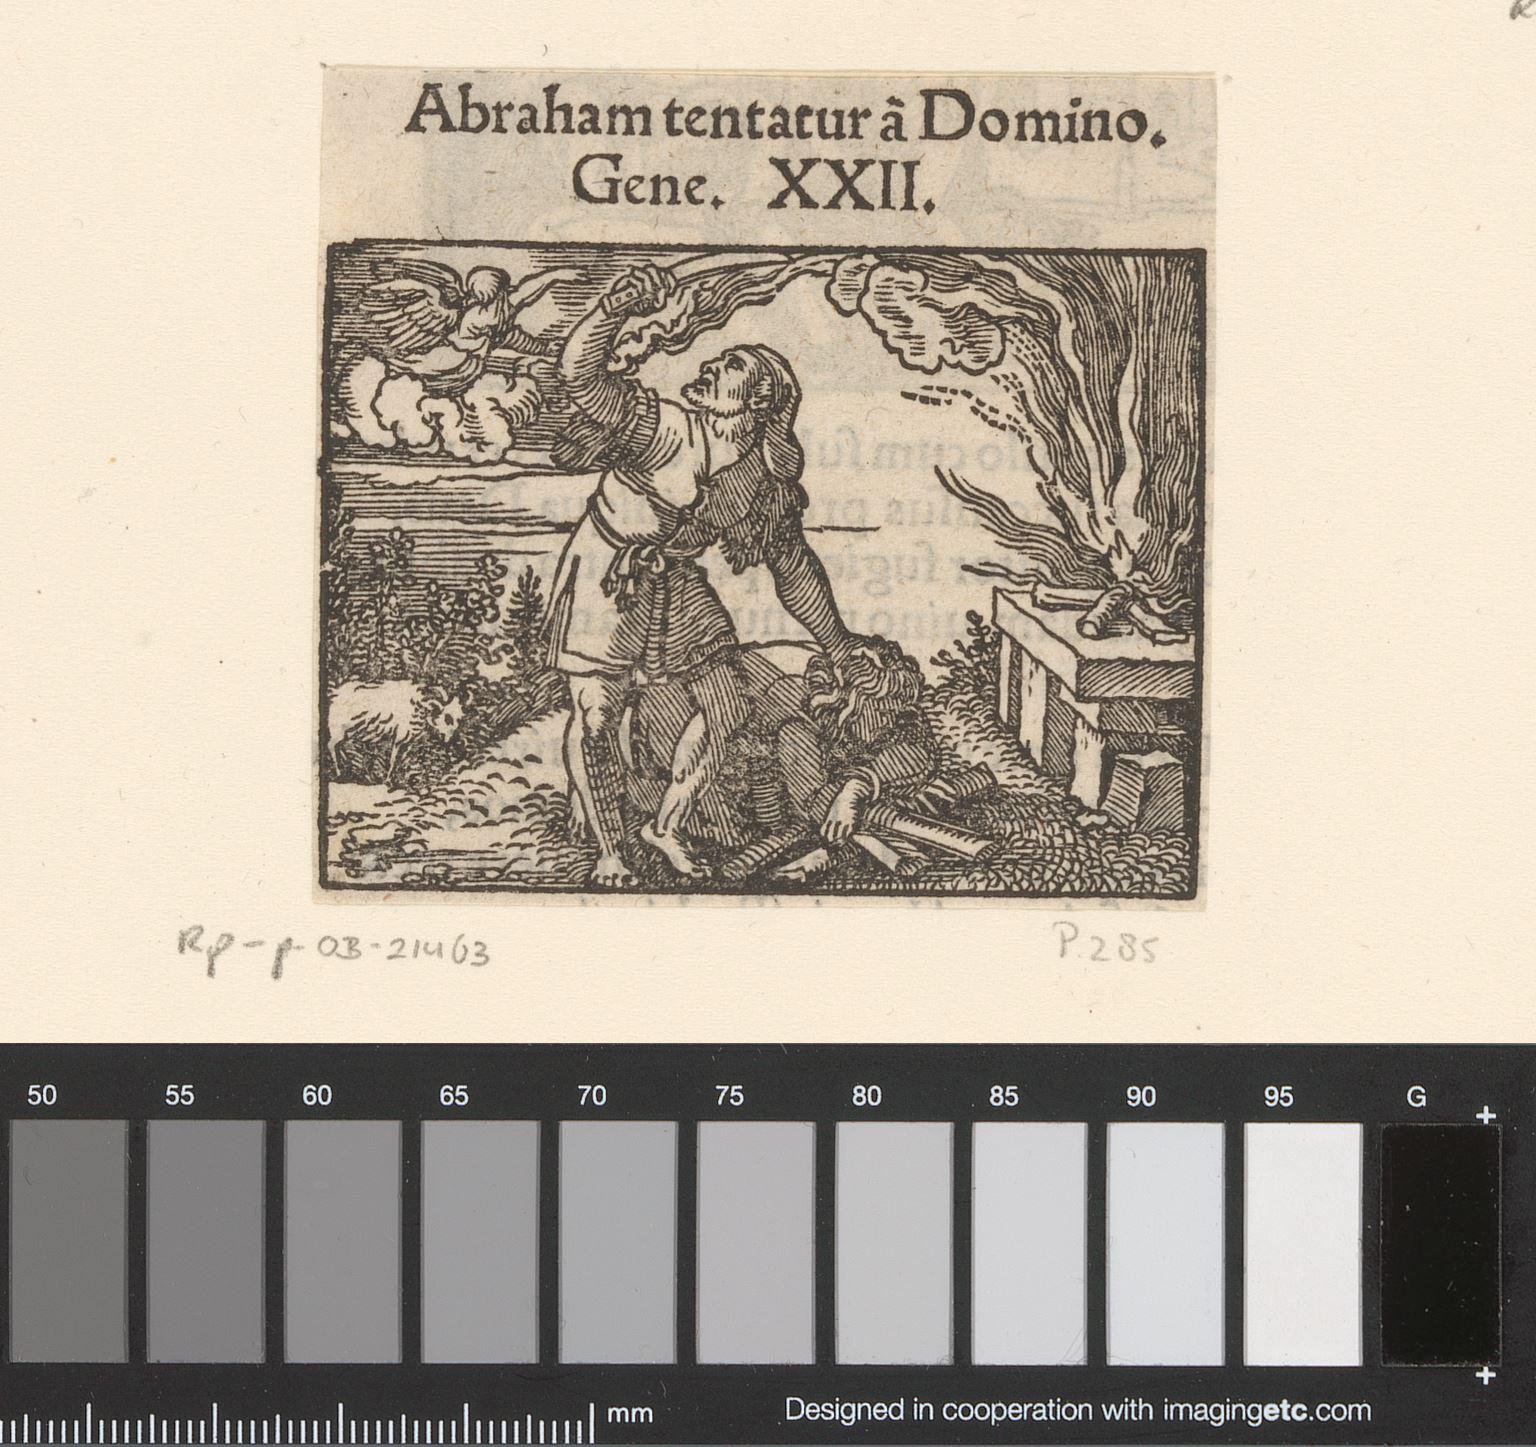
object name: print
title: Abraham tentatur à Domino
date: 1530-1533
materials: paper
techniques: letterpress printing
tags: when abraham has his hand raised to kill isaac, an angel restrains abraham's hand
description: Prent afkomstig uit: Biblicae historiae. Frankfurt am Main: Egenloph, 1539.